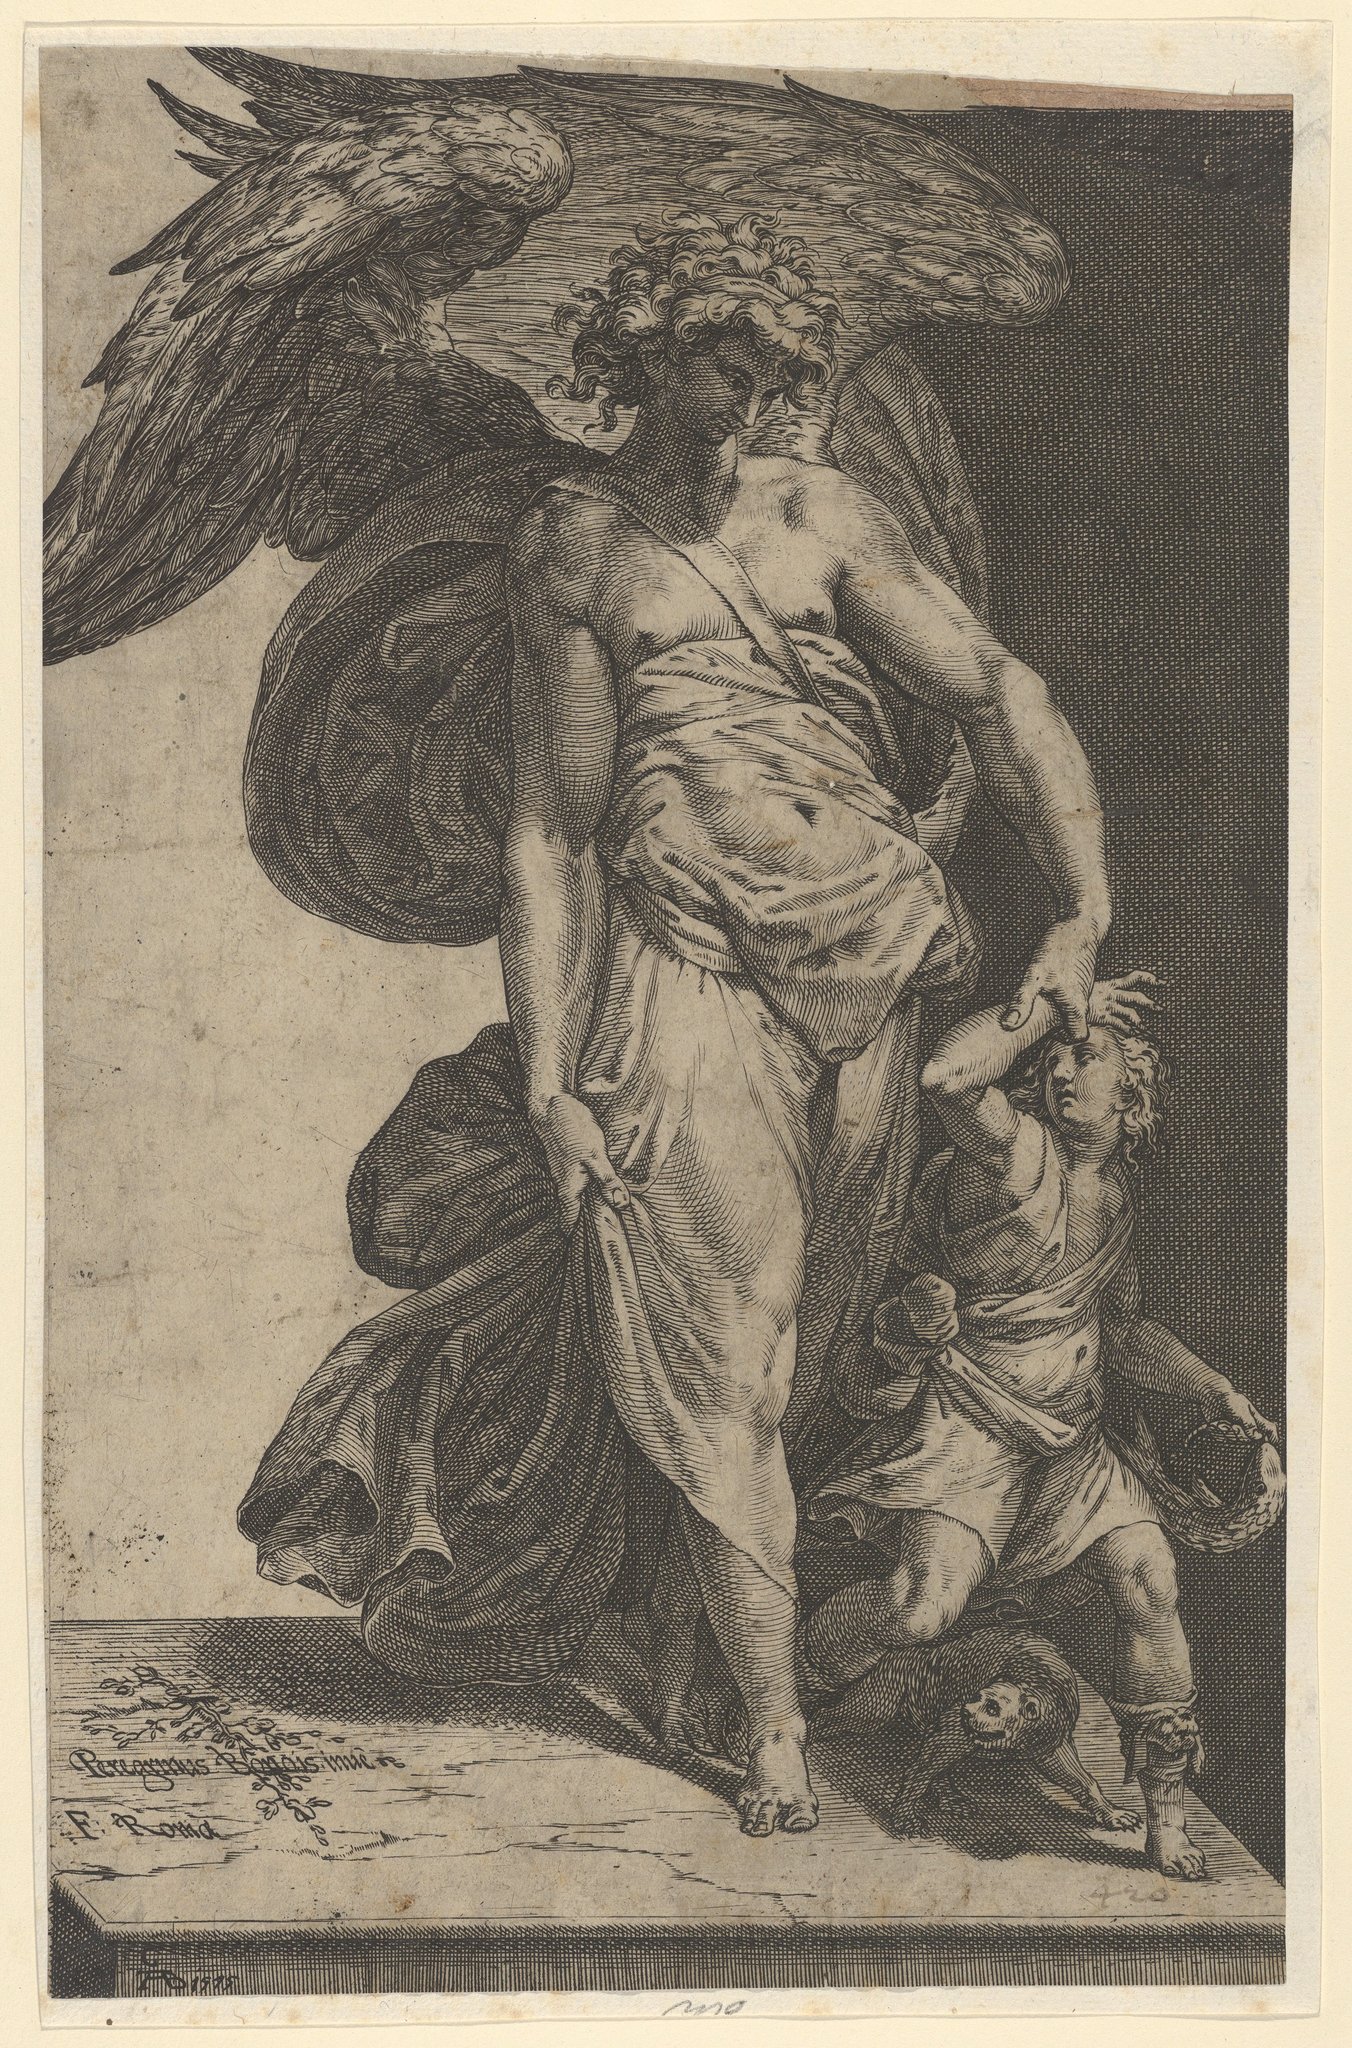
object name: print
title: Tobias and the Angel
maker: cherubino alberti (zaccaria mattia)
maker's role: artist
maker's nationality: italian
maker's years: 1553-1615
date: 1575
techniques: engraving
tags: angels